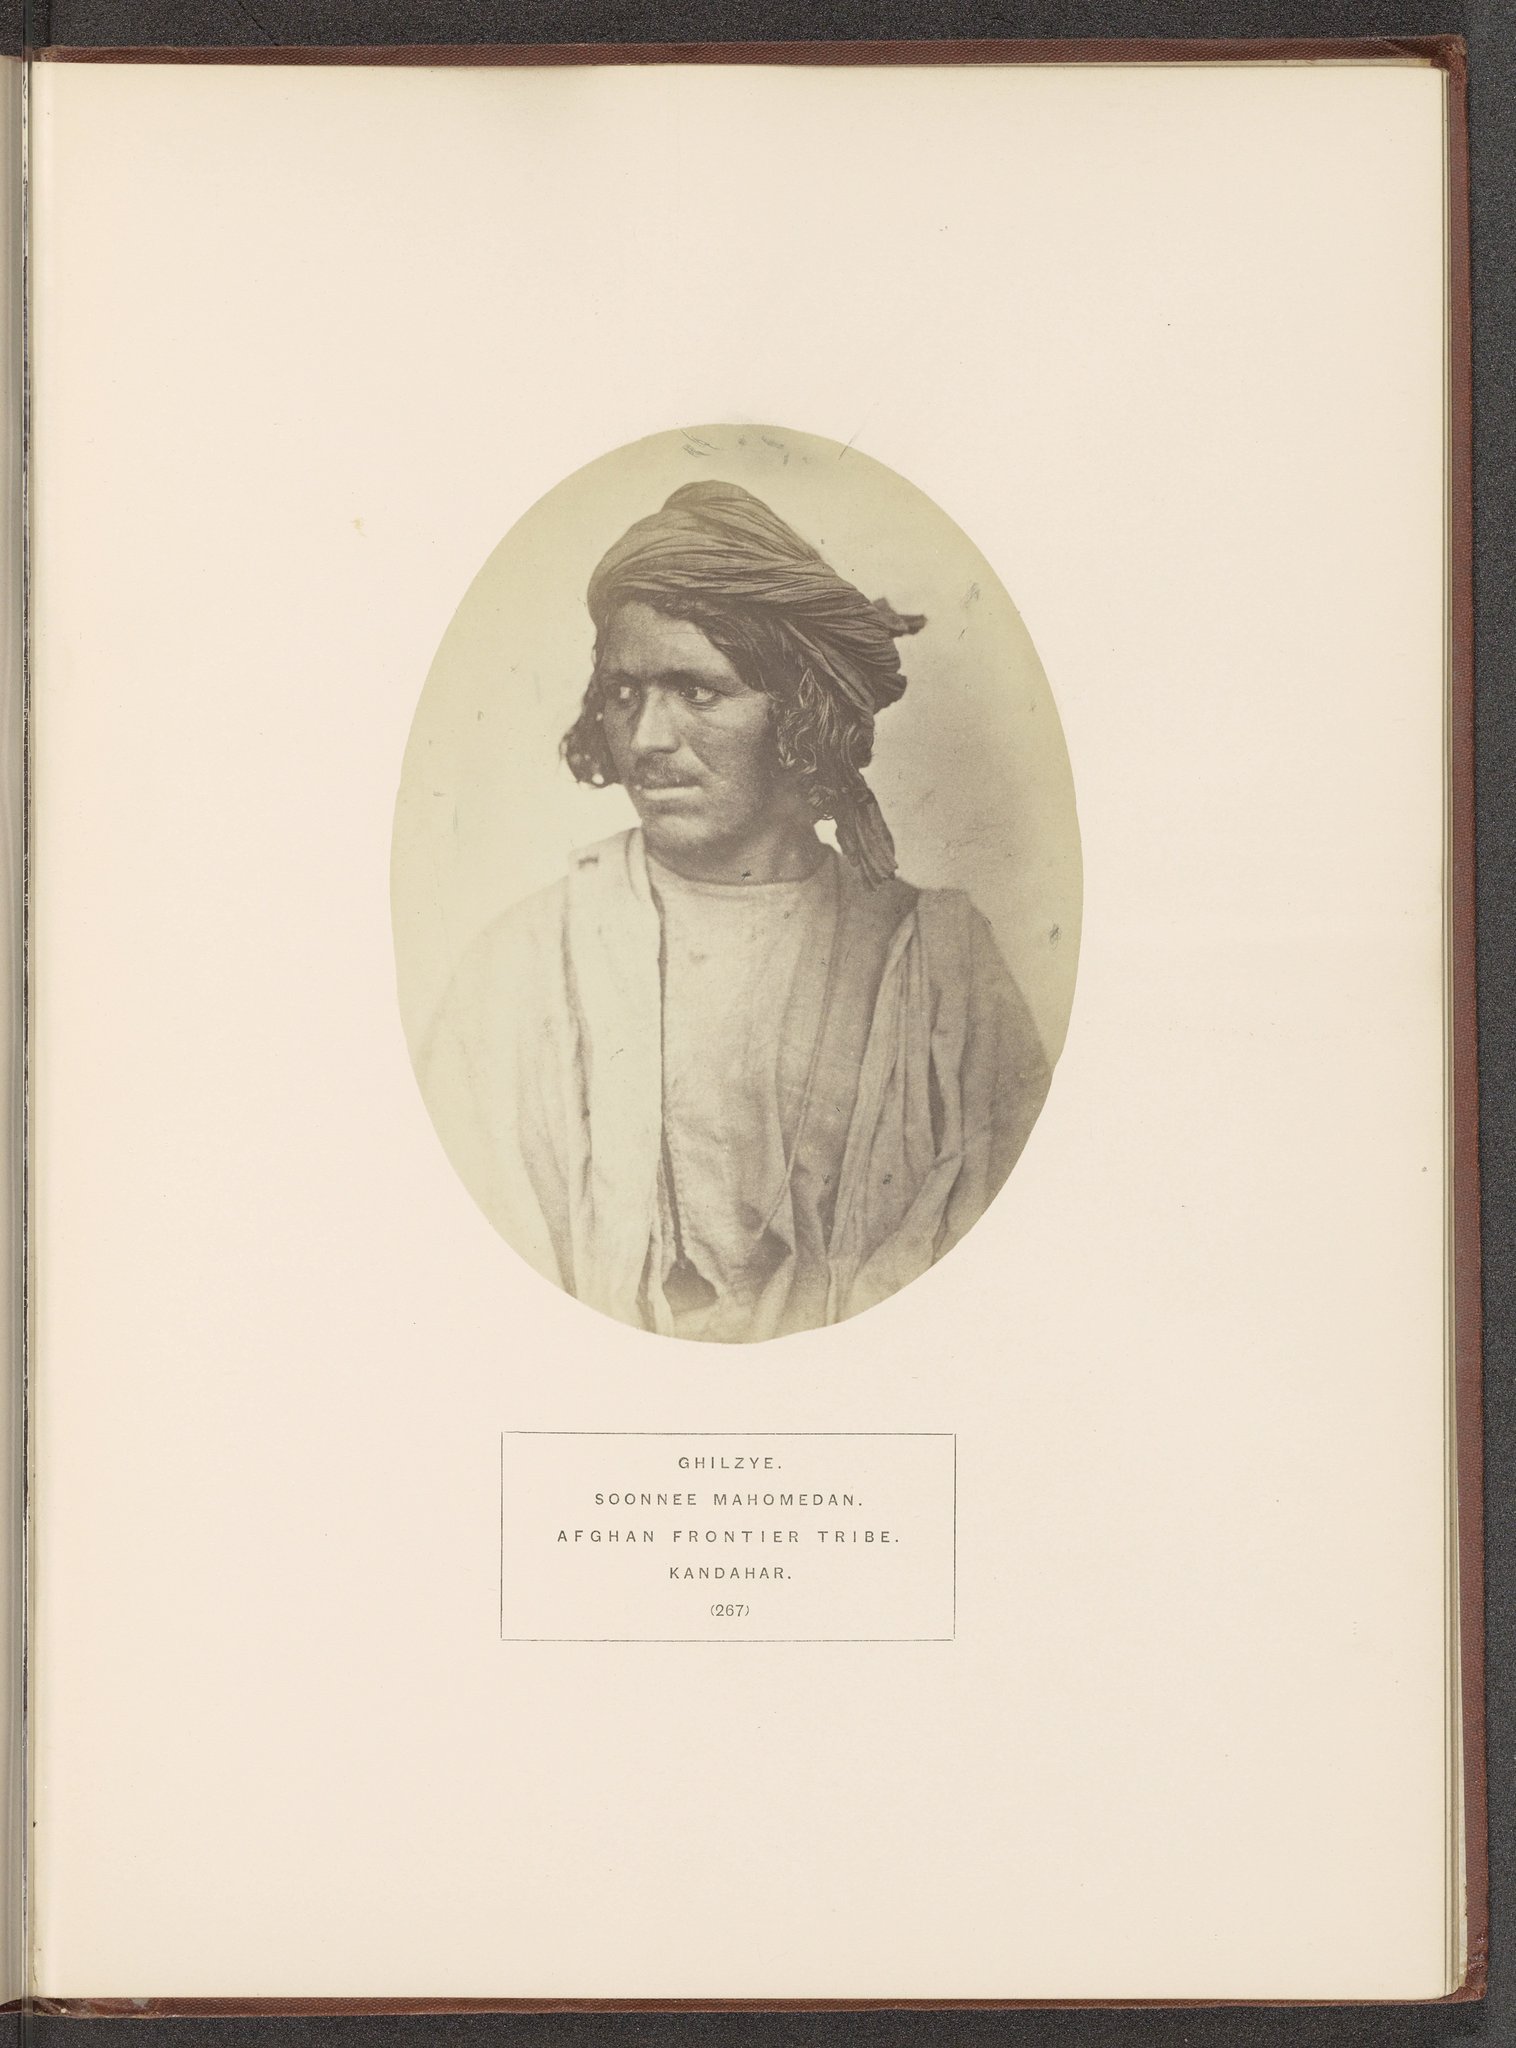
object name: photograph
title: Portrait of an unknown man from the Ghilzai tribe of Kandahar, Afghanistan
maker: Anonymous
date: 1862-1872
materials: photographic support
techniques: albumen print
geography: kandahar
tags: head-gear: turban, human races; peoples; nationalities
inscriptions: number: ‘(267)’, inscription: ‘GHILZYE./ SOONNEE MAHOMEDAN./ AFGHAN FRONTIER TRIBE./ KANDAHAR.’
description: De Ghilzai-stam is ook bekend als Ghilji.